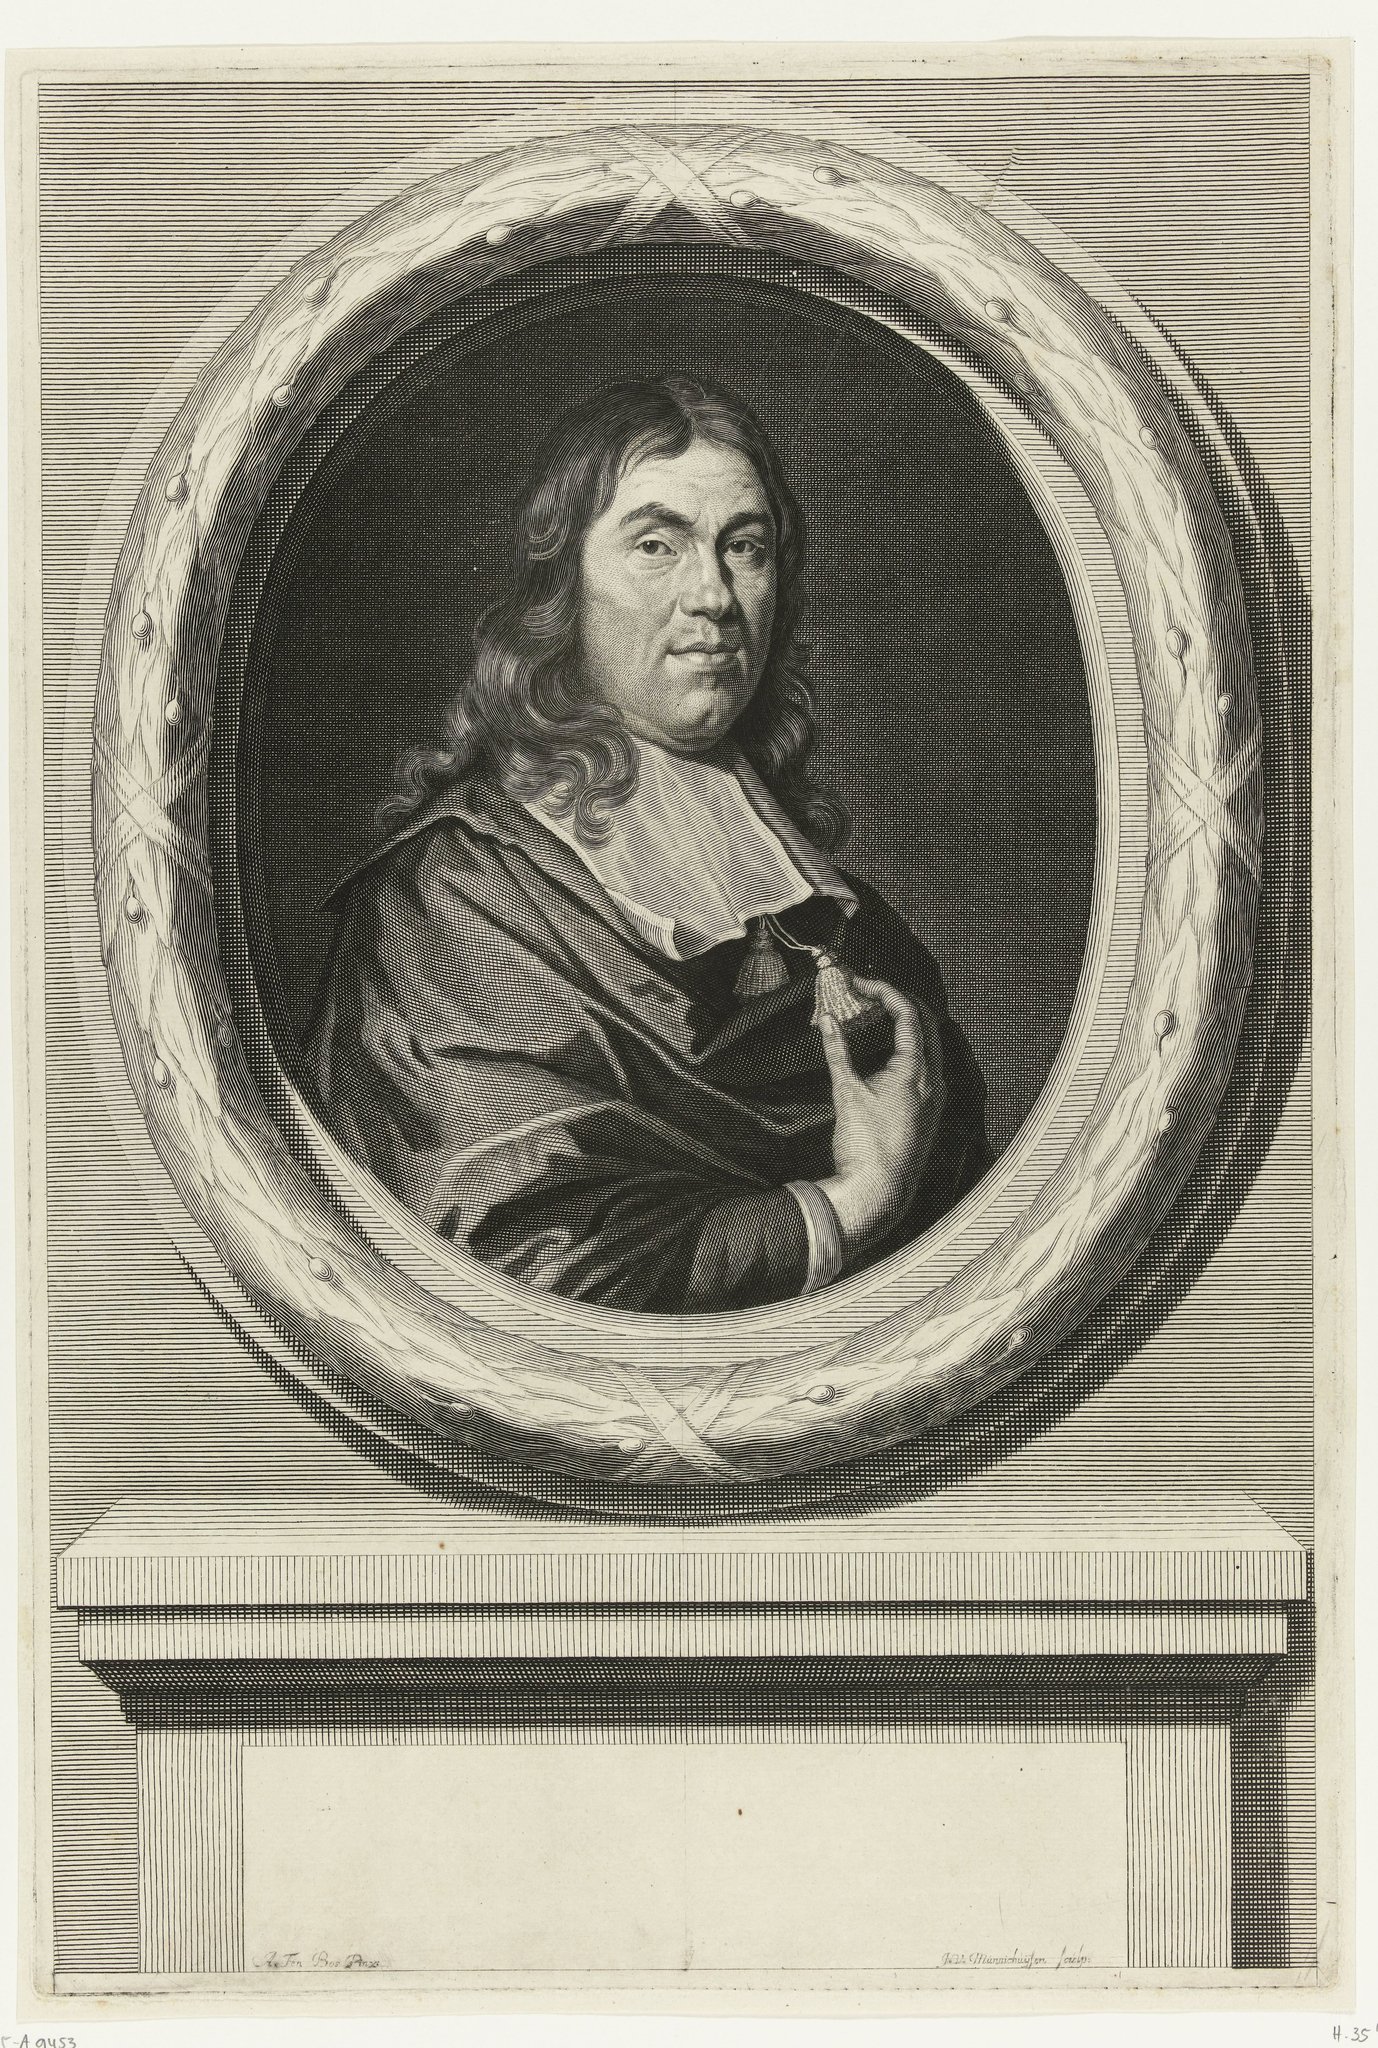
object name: print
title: Portret van Jan de Wys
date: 1664-1721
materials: paper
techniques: engraving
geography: netherlands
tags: jan de wys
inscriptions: collector's mark: Lugt 2228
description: Portret van Jan de Wys, makelaar in verfstoffen te Amsterdam.